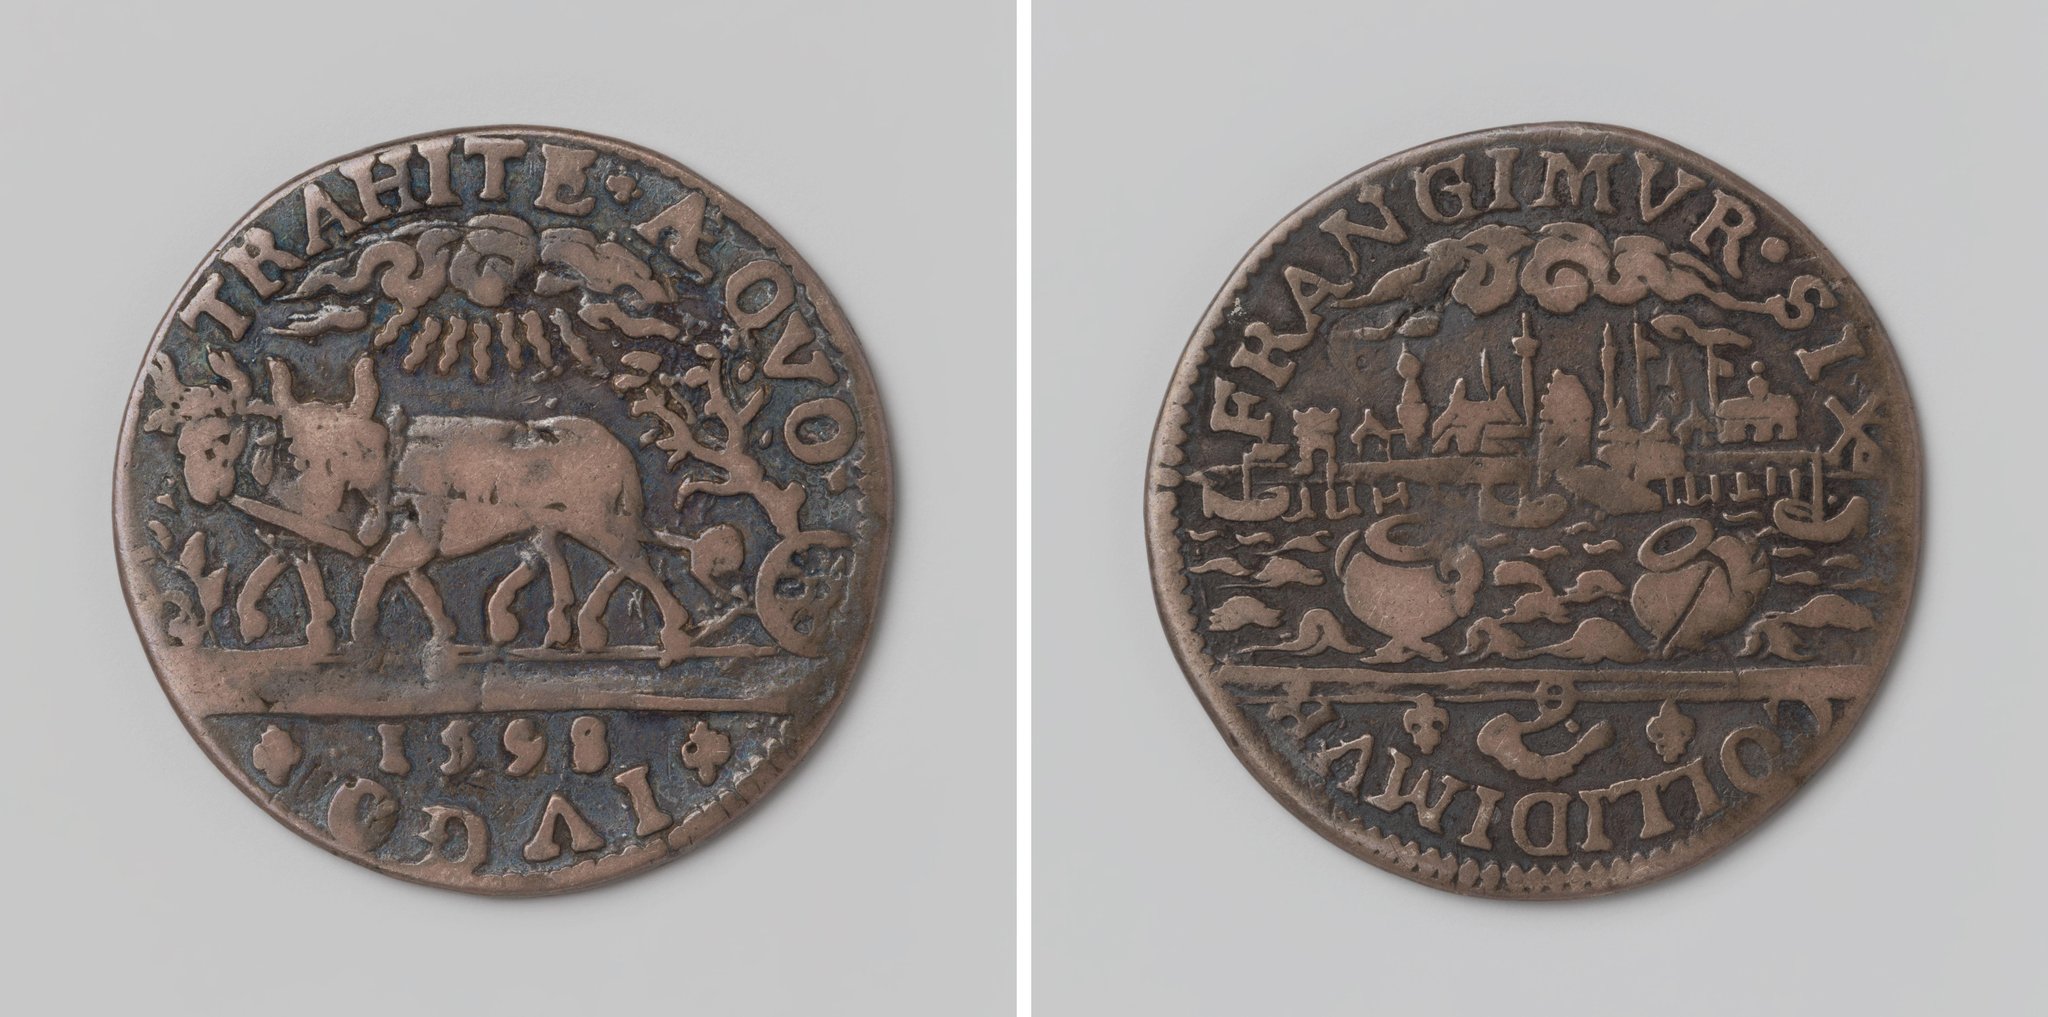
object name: jeton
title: Aansporing tot eendracht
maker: Anonymous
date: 1598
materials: silver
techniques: striking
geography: hoorn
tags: tachtigjarige oorlog